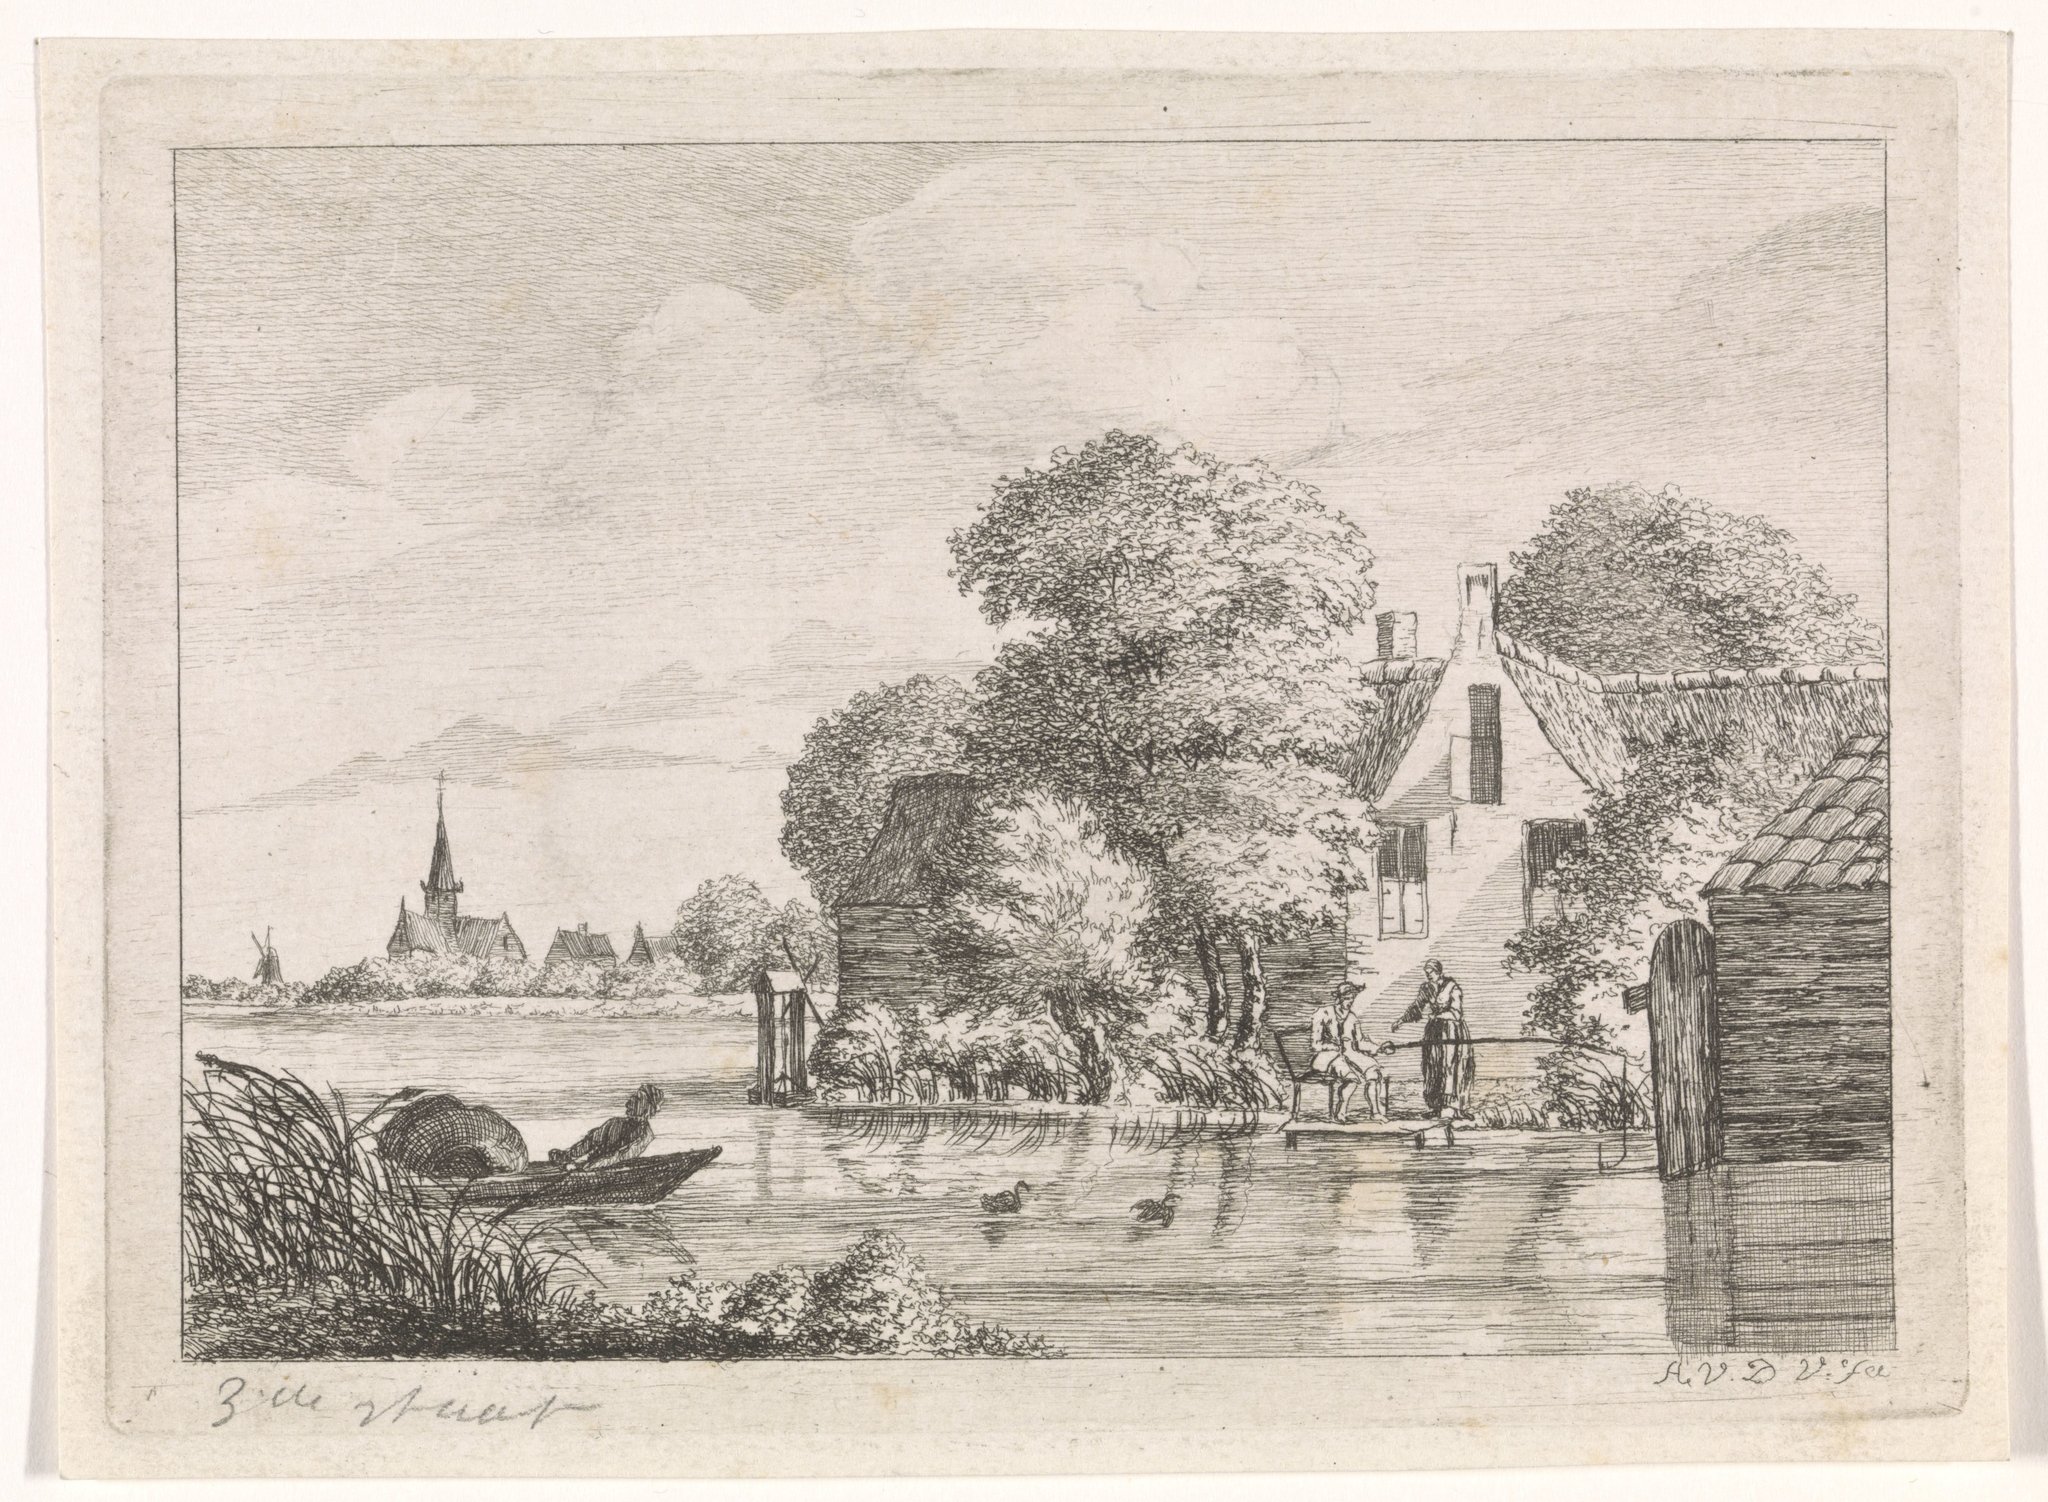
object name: print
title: Hengelaar en een vrouw voor een huis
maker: a. van de velde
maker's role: print maker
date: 1700-1800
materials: paper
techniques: etching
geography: netherlands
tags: church (exterior), rowing facing backward, pulling, angling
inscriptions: collector's mark: Lugt 2228, inscription: ‘3de staat’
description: Rechts voor een huis zit een man op een steiger te hengelen terwijl een vrouw bij hem staat. Links in het verschiet een dorpskerk. Op het water en man in een roeiboot waarin een rieten fuik.